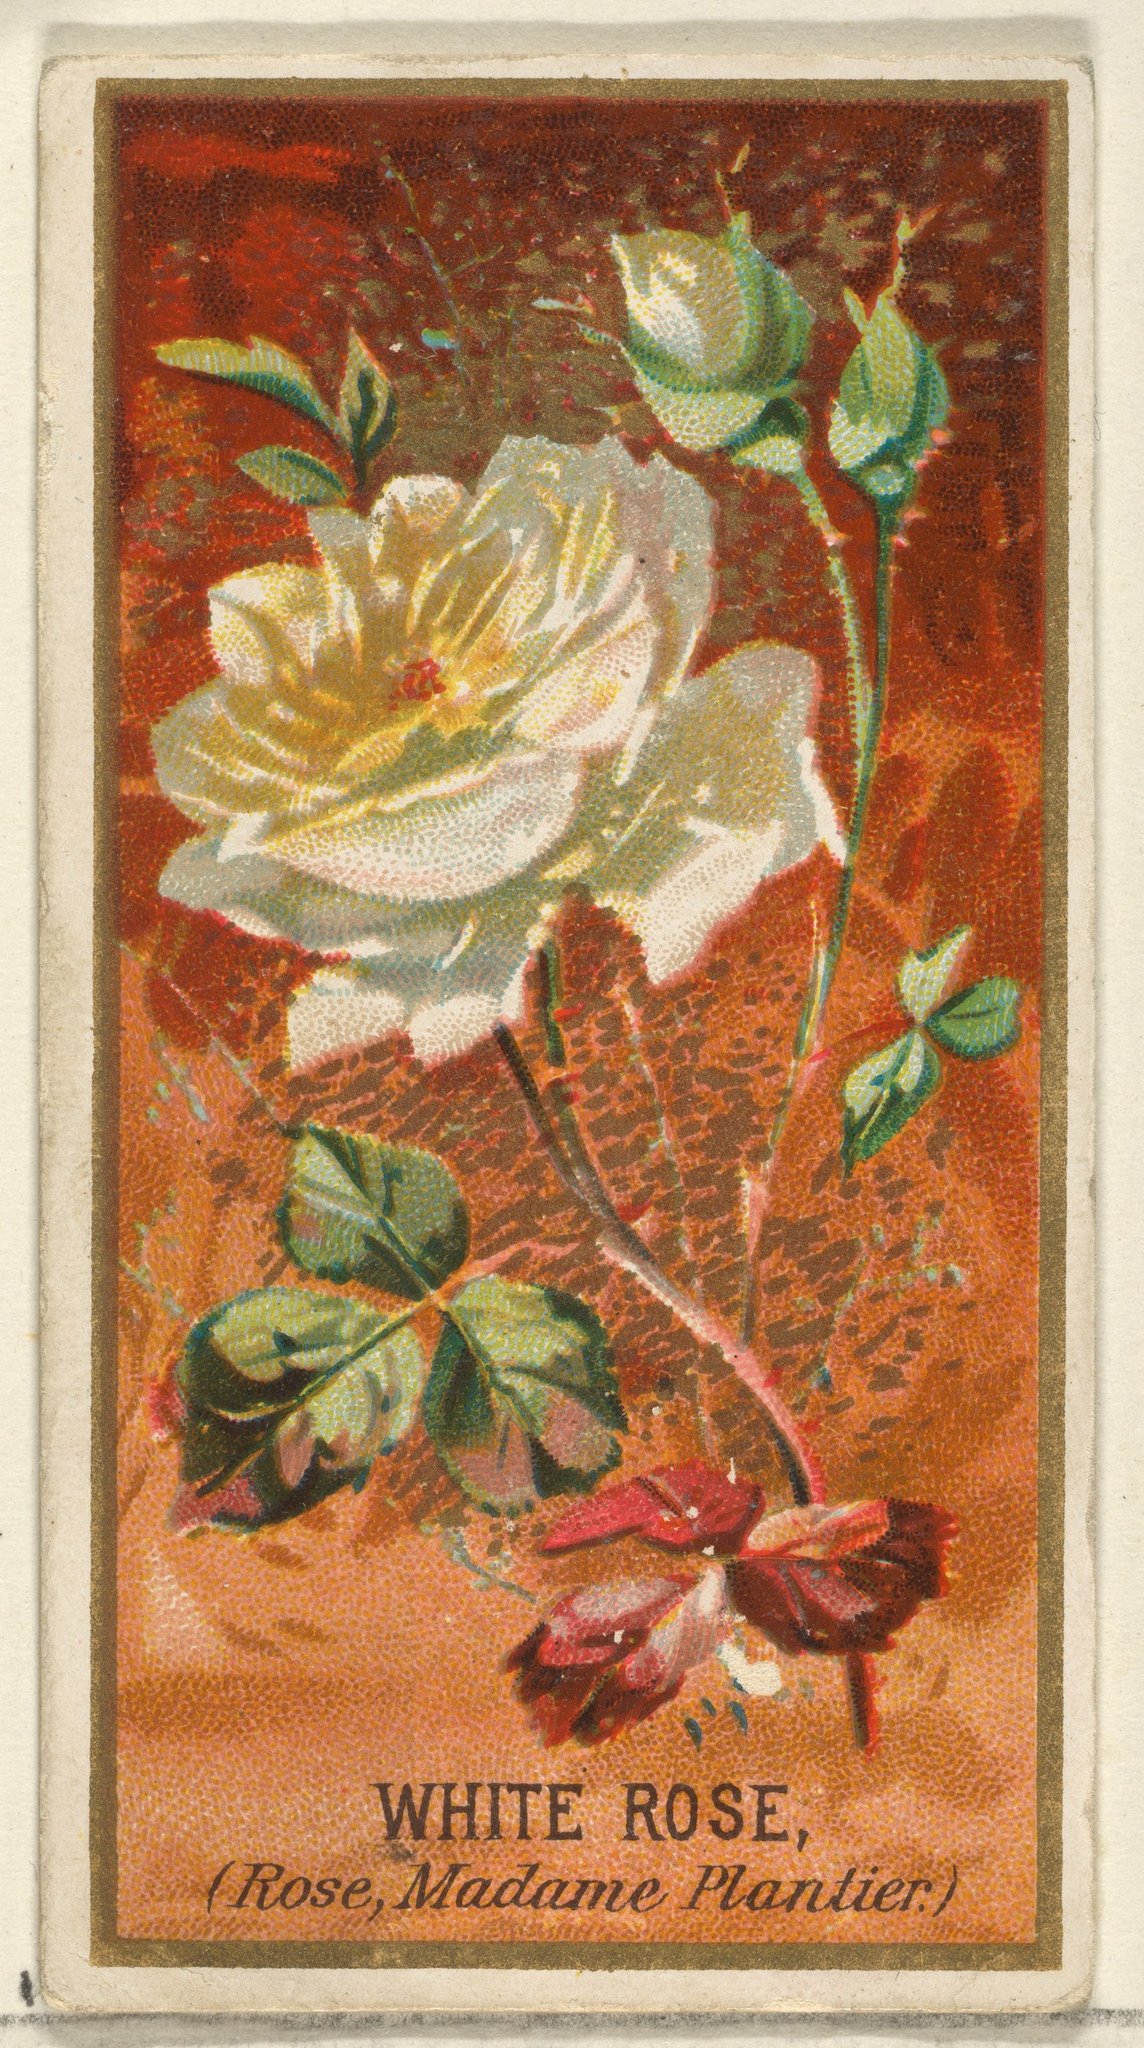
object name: print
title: White Rose (Rose, Madame Plantier), from the Flowers series for Old Judge Cigarettes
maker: goodwin & company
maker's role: publisher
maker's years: 1850-1950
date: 1890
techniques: color lithograph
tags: roses,leaves